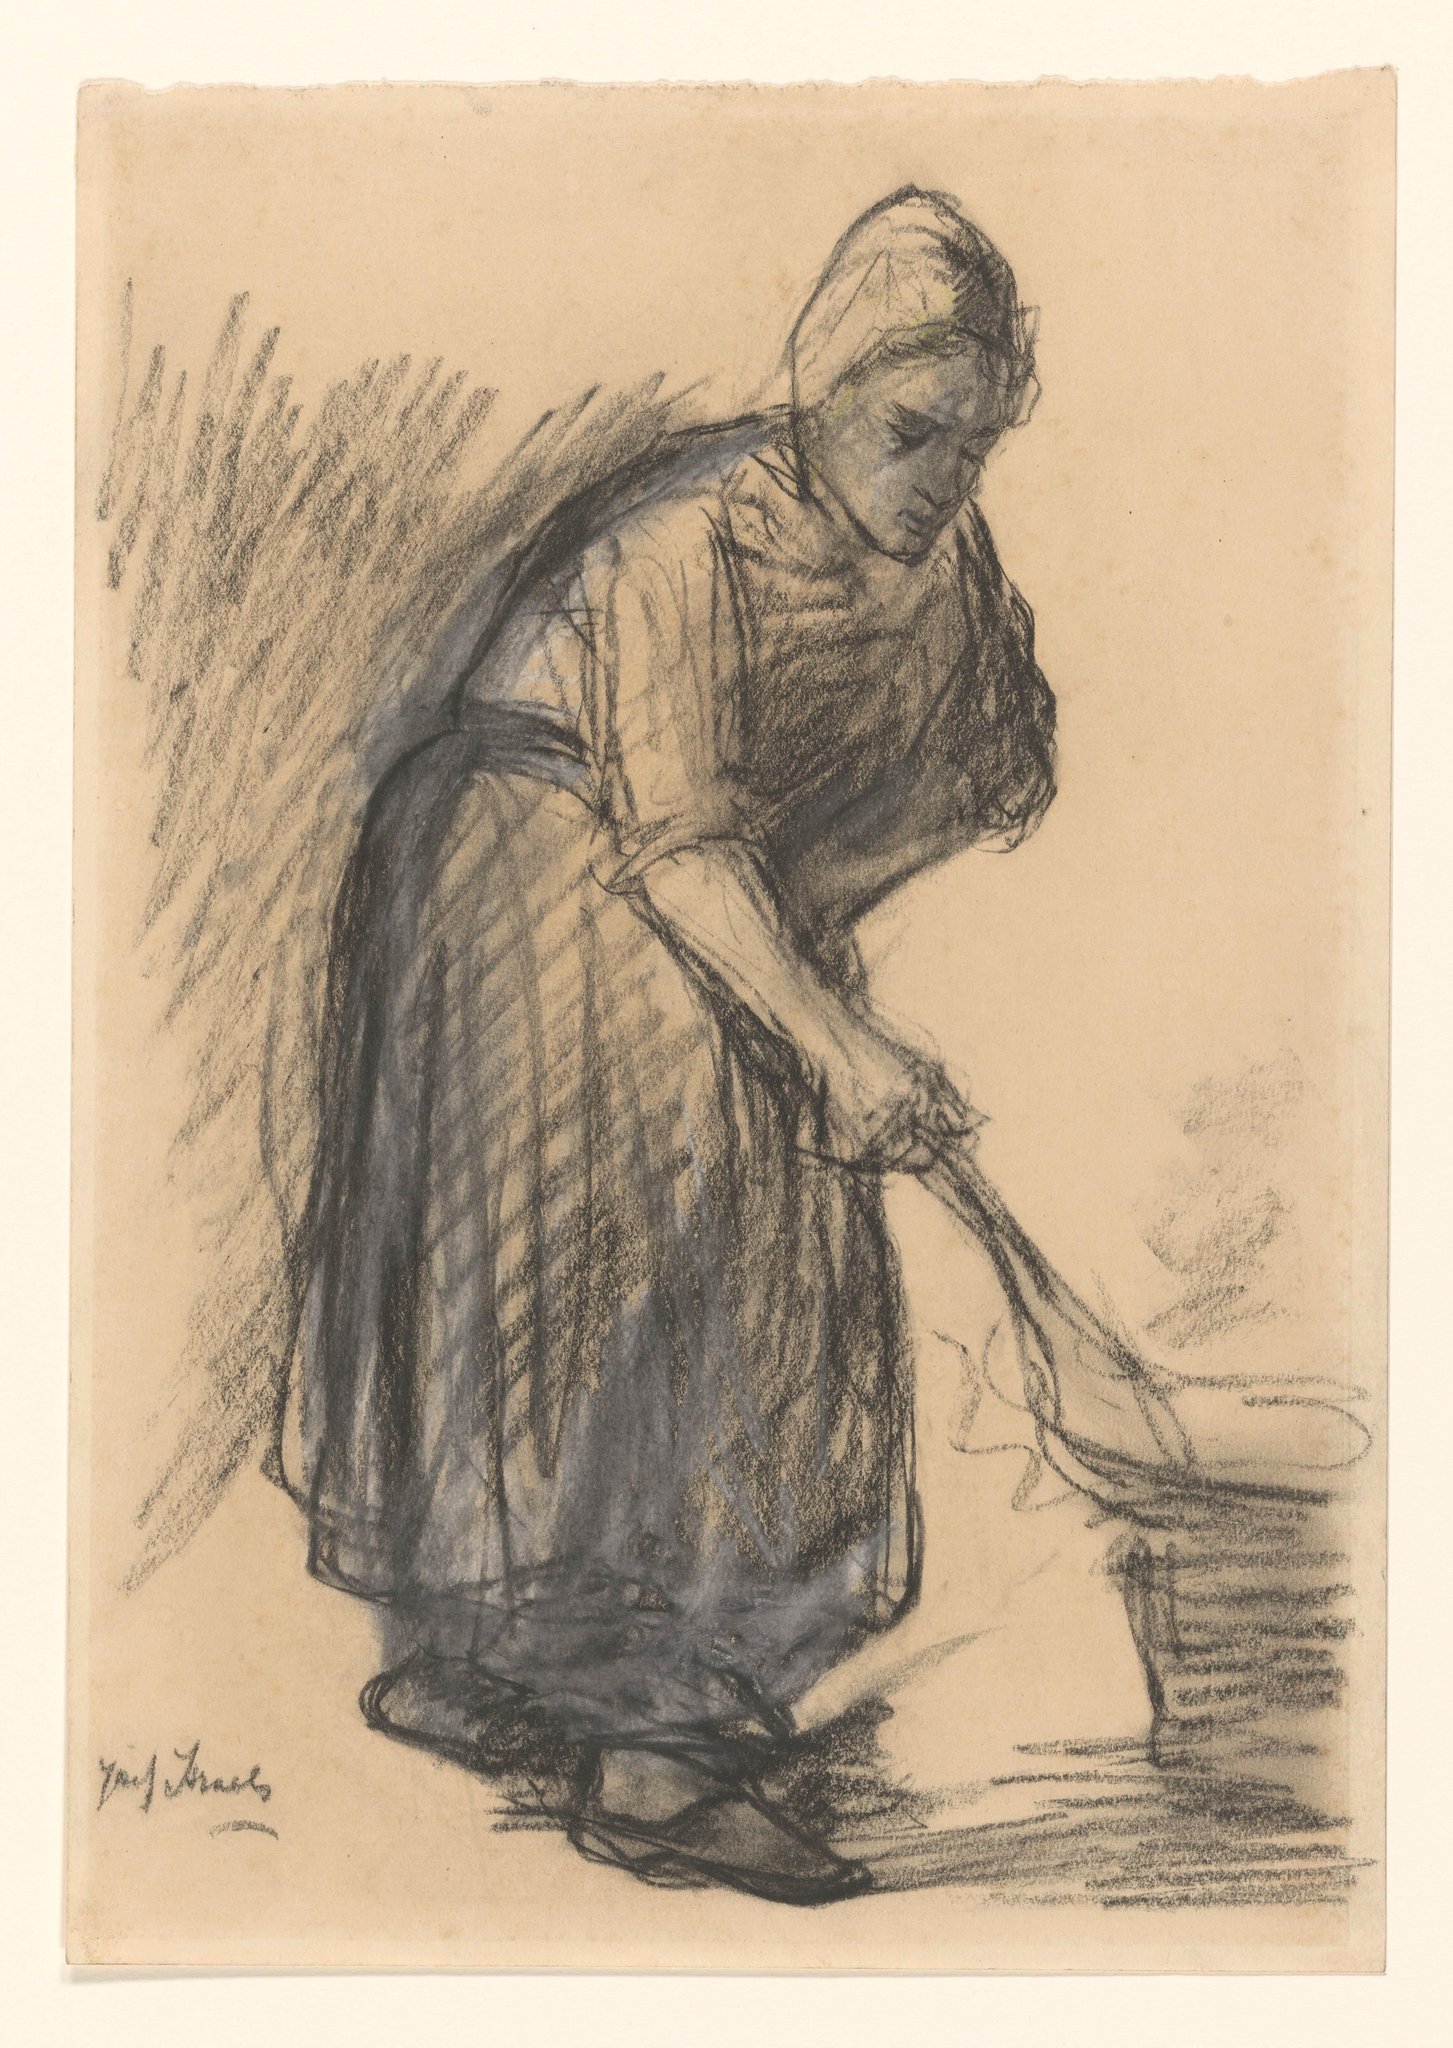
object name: drawing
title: Boerin die een koekenpan op het vuur houdt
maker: jozef israëls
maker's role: draughtsman, painter, print maker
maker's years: 1824-1911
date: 1834-1911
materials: chalk, paper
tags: frying